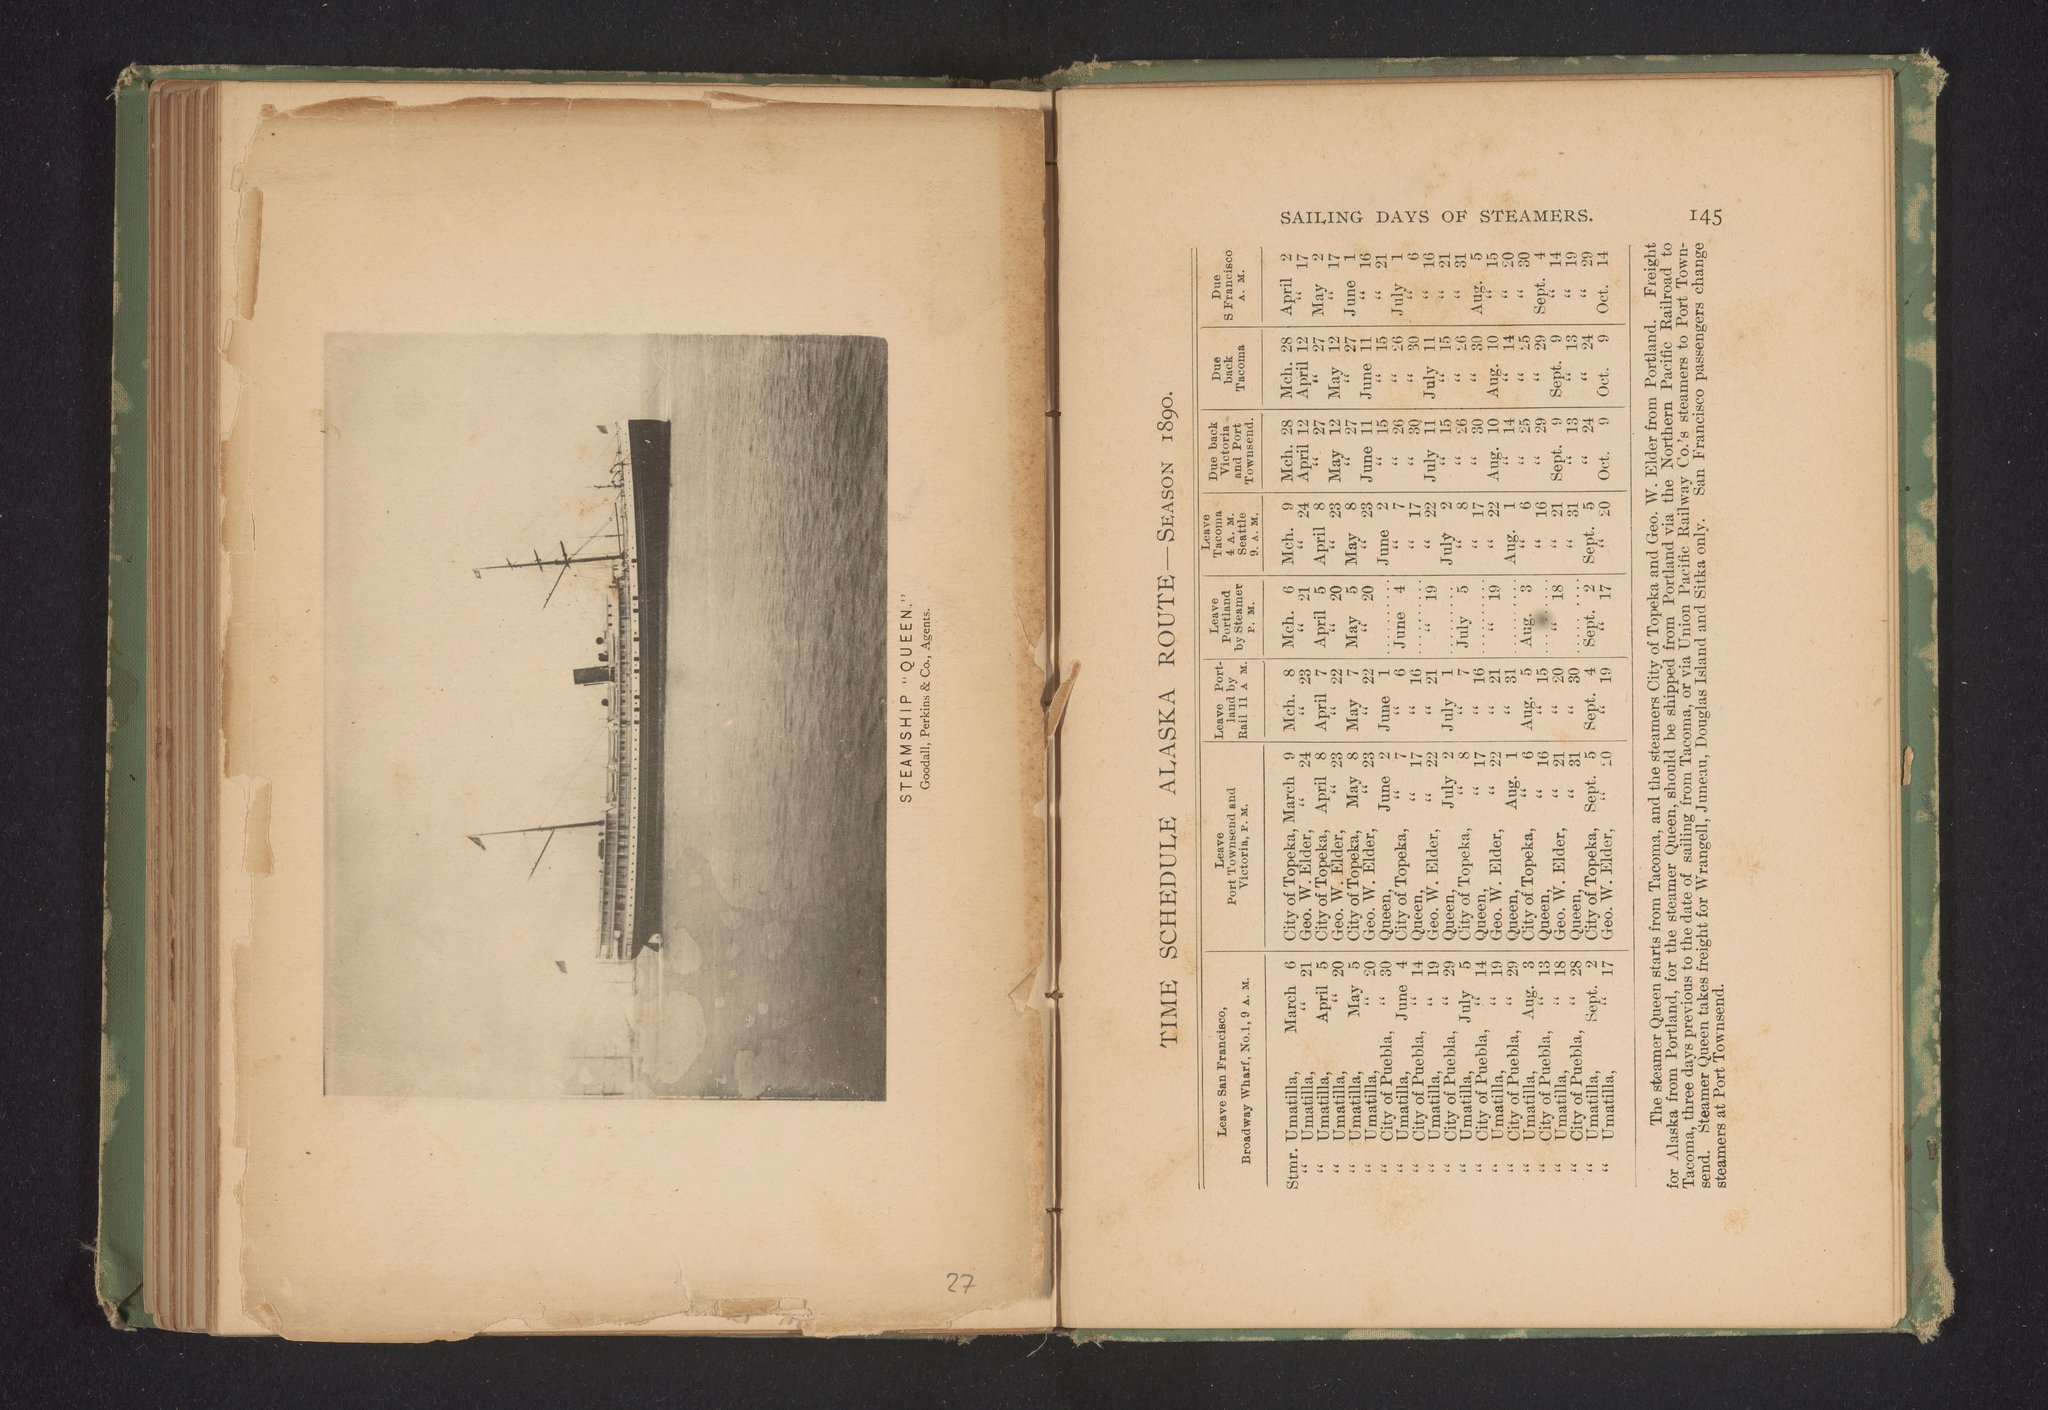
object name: page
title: Steamship Queen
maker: Anonymous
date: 1885-1890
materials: paper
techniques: photograph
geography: alaska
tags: ships (in general)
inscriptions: inscription: ‘Goodall, Perkins & Co., Agents.’